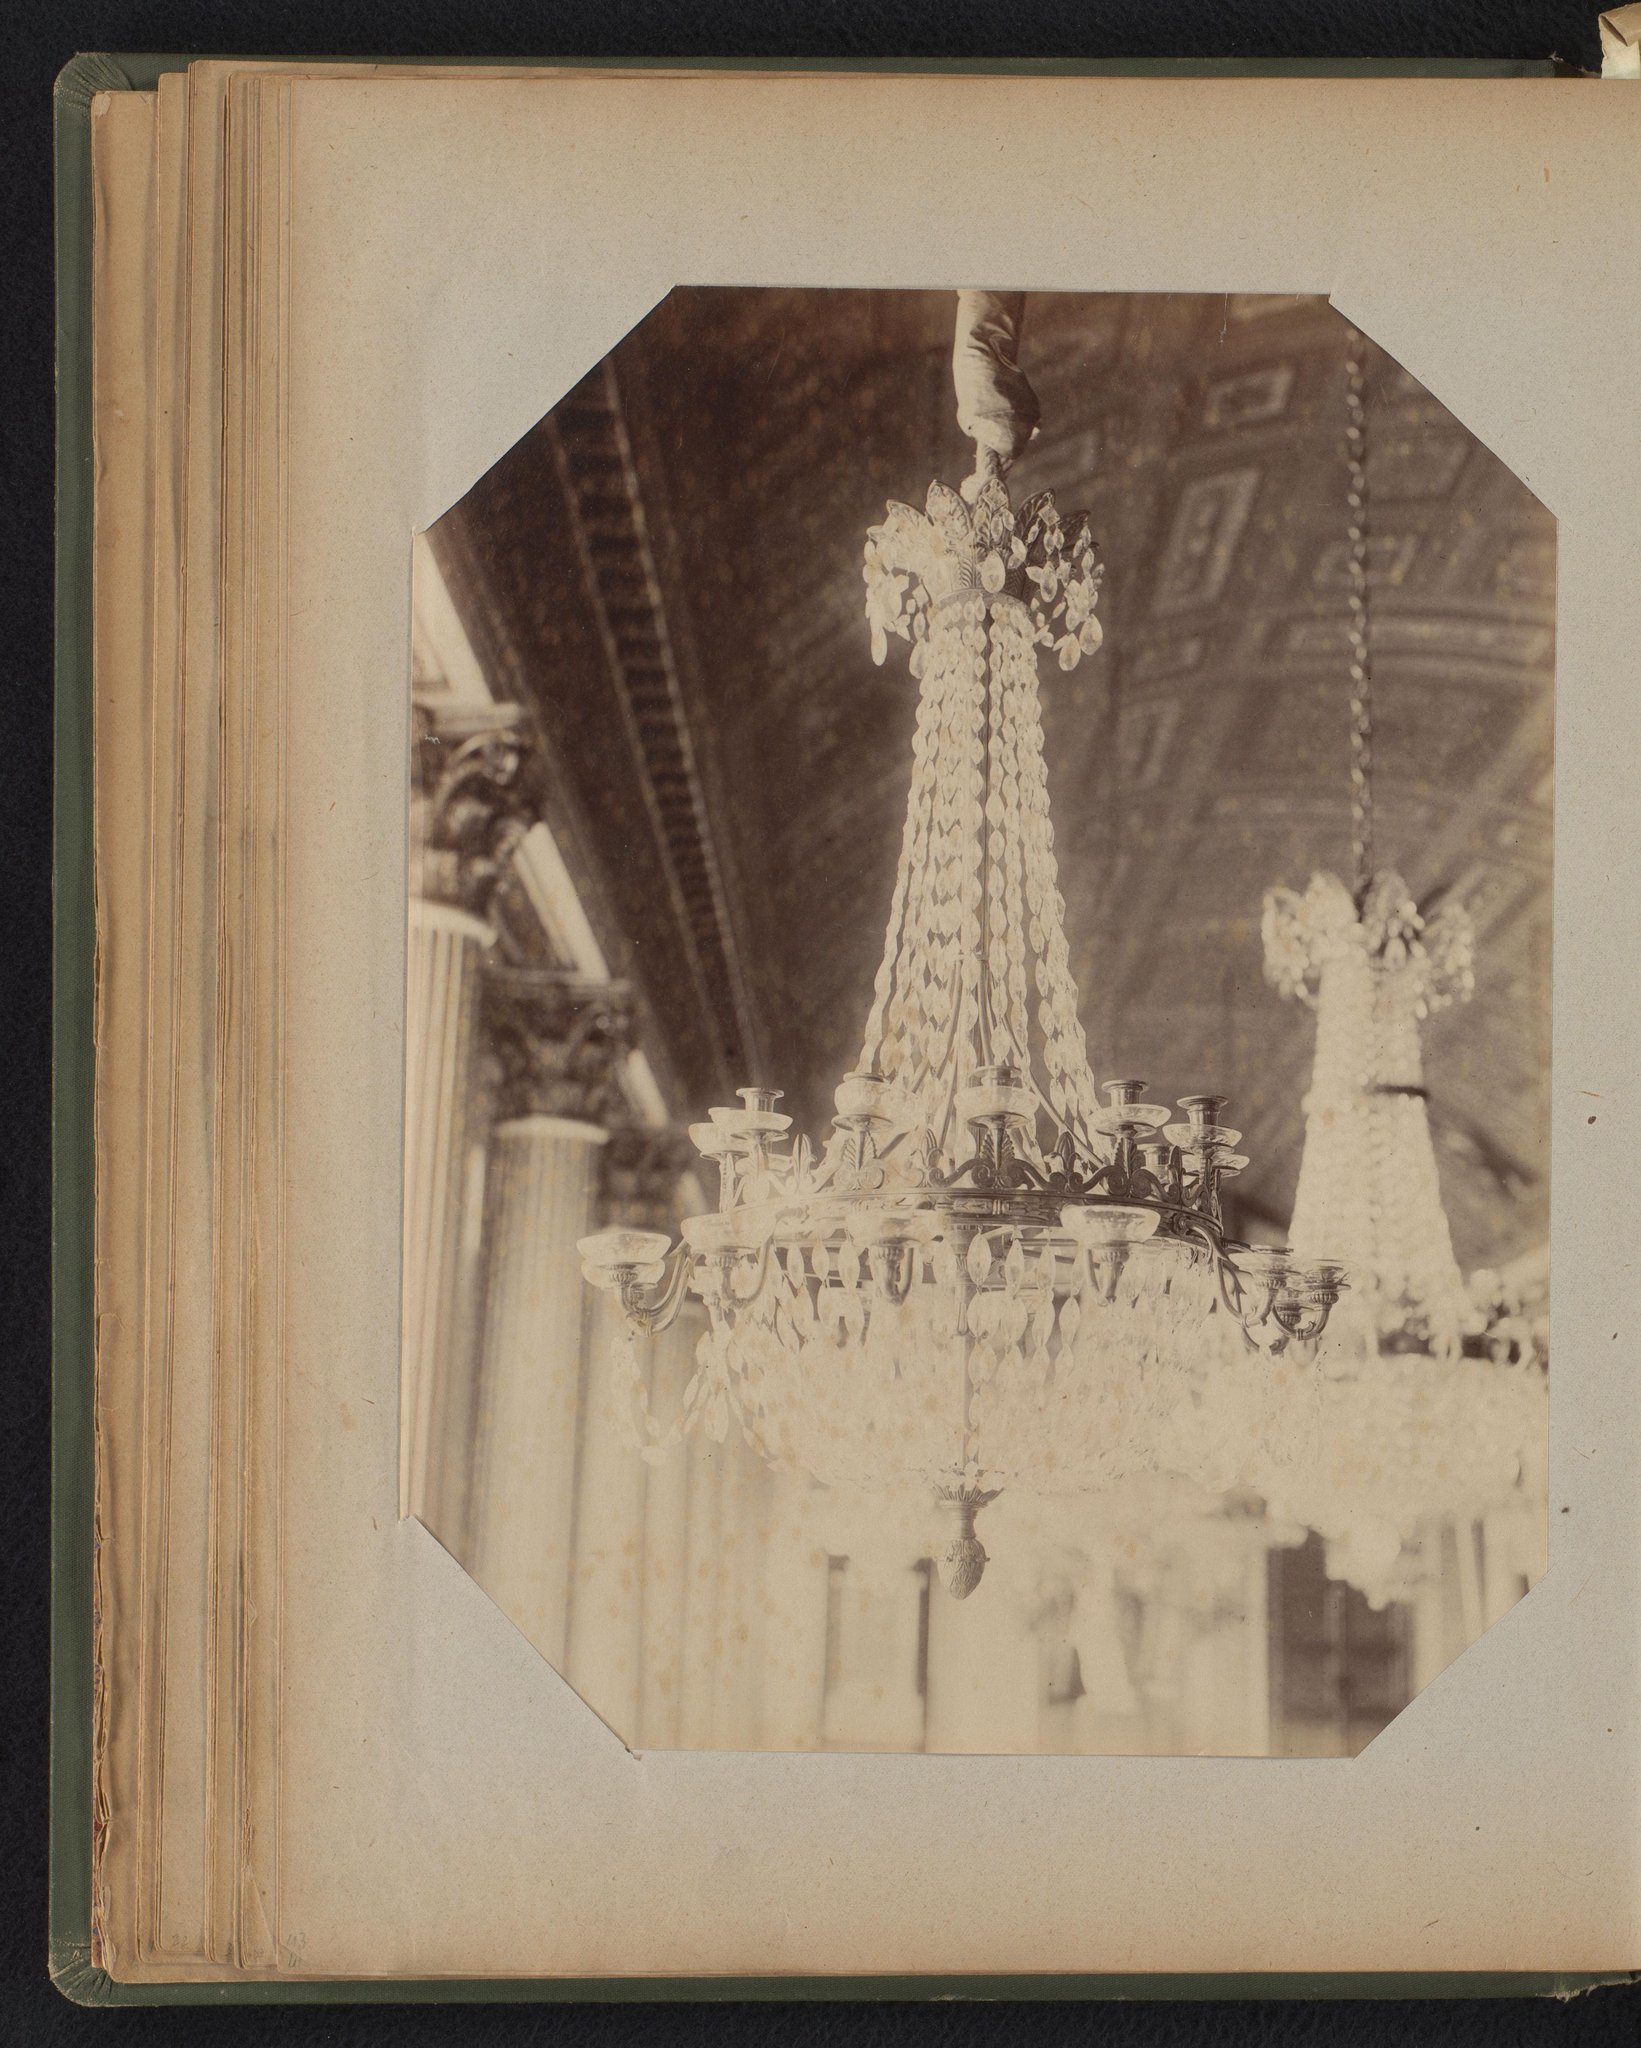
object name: photograph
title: Bronzen kroonluchter met kristallen lijnen en druppelvangers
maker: Anonymous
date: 1860-1900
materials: paper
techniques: albumen print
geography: netherlands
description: Onderdeel van een serie met betrekking tot het interieur van het paleis van Versailles met kroonluchters, deuren, portalen en meubelstukken.